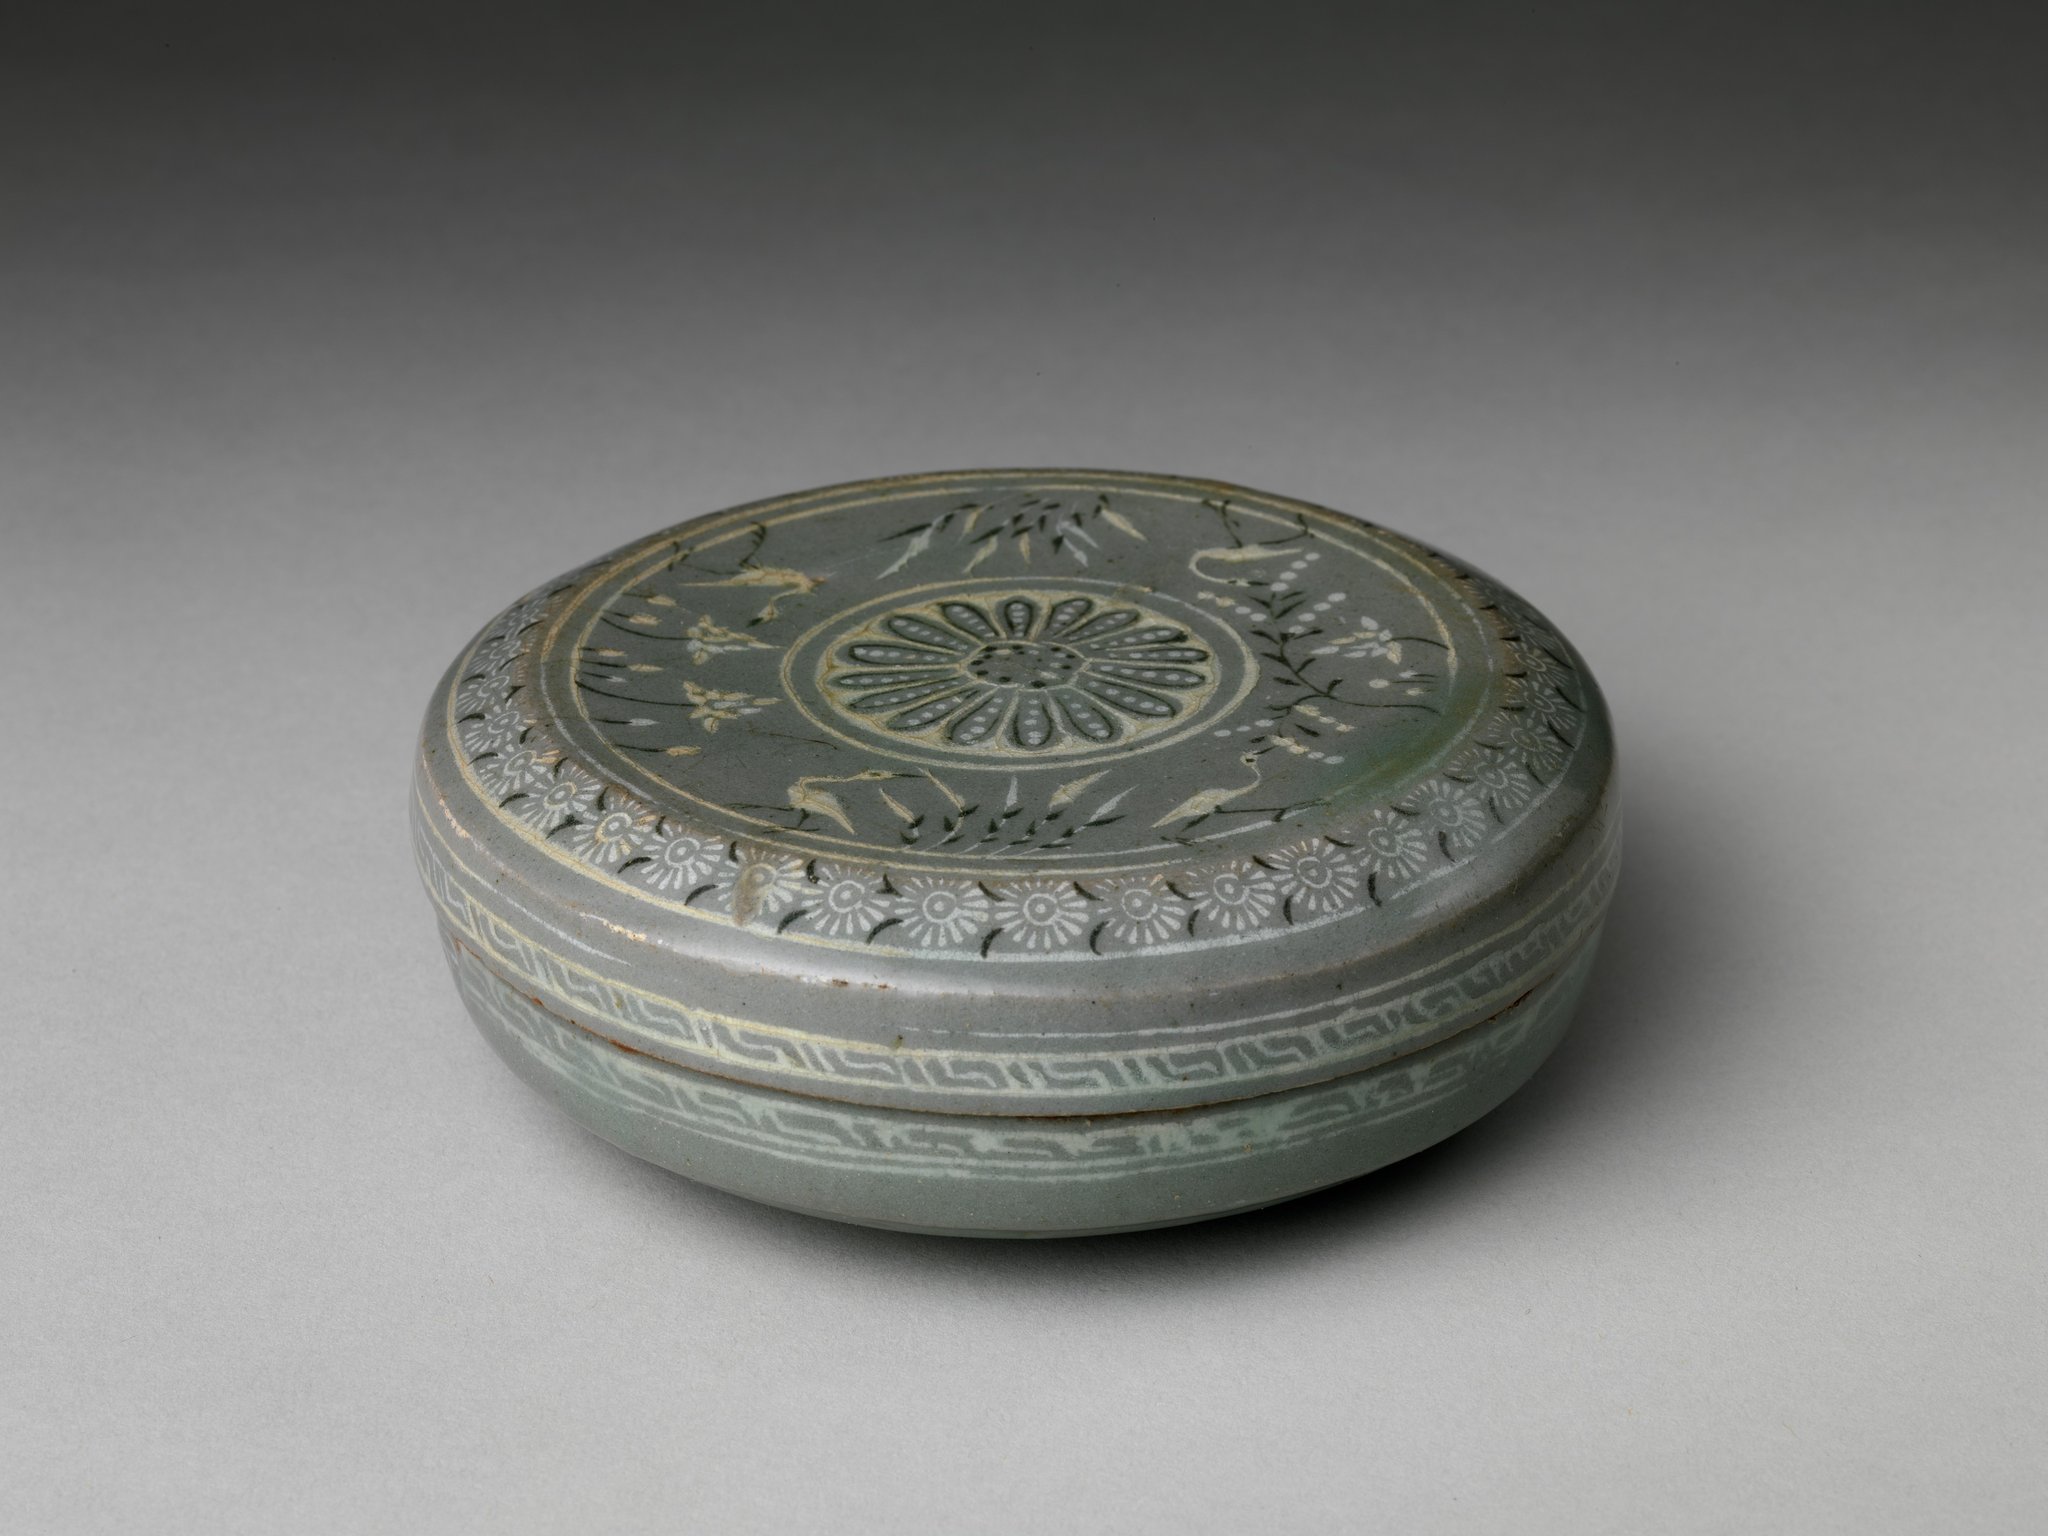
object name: covered box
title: Covered box decorated with chrysanthemums and waterfowl among lotus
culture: korean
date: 1201-1300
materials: ceramic glaze, glaze, stoneware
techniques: inlay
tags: birds,flowers